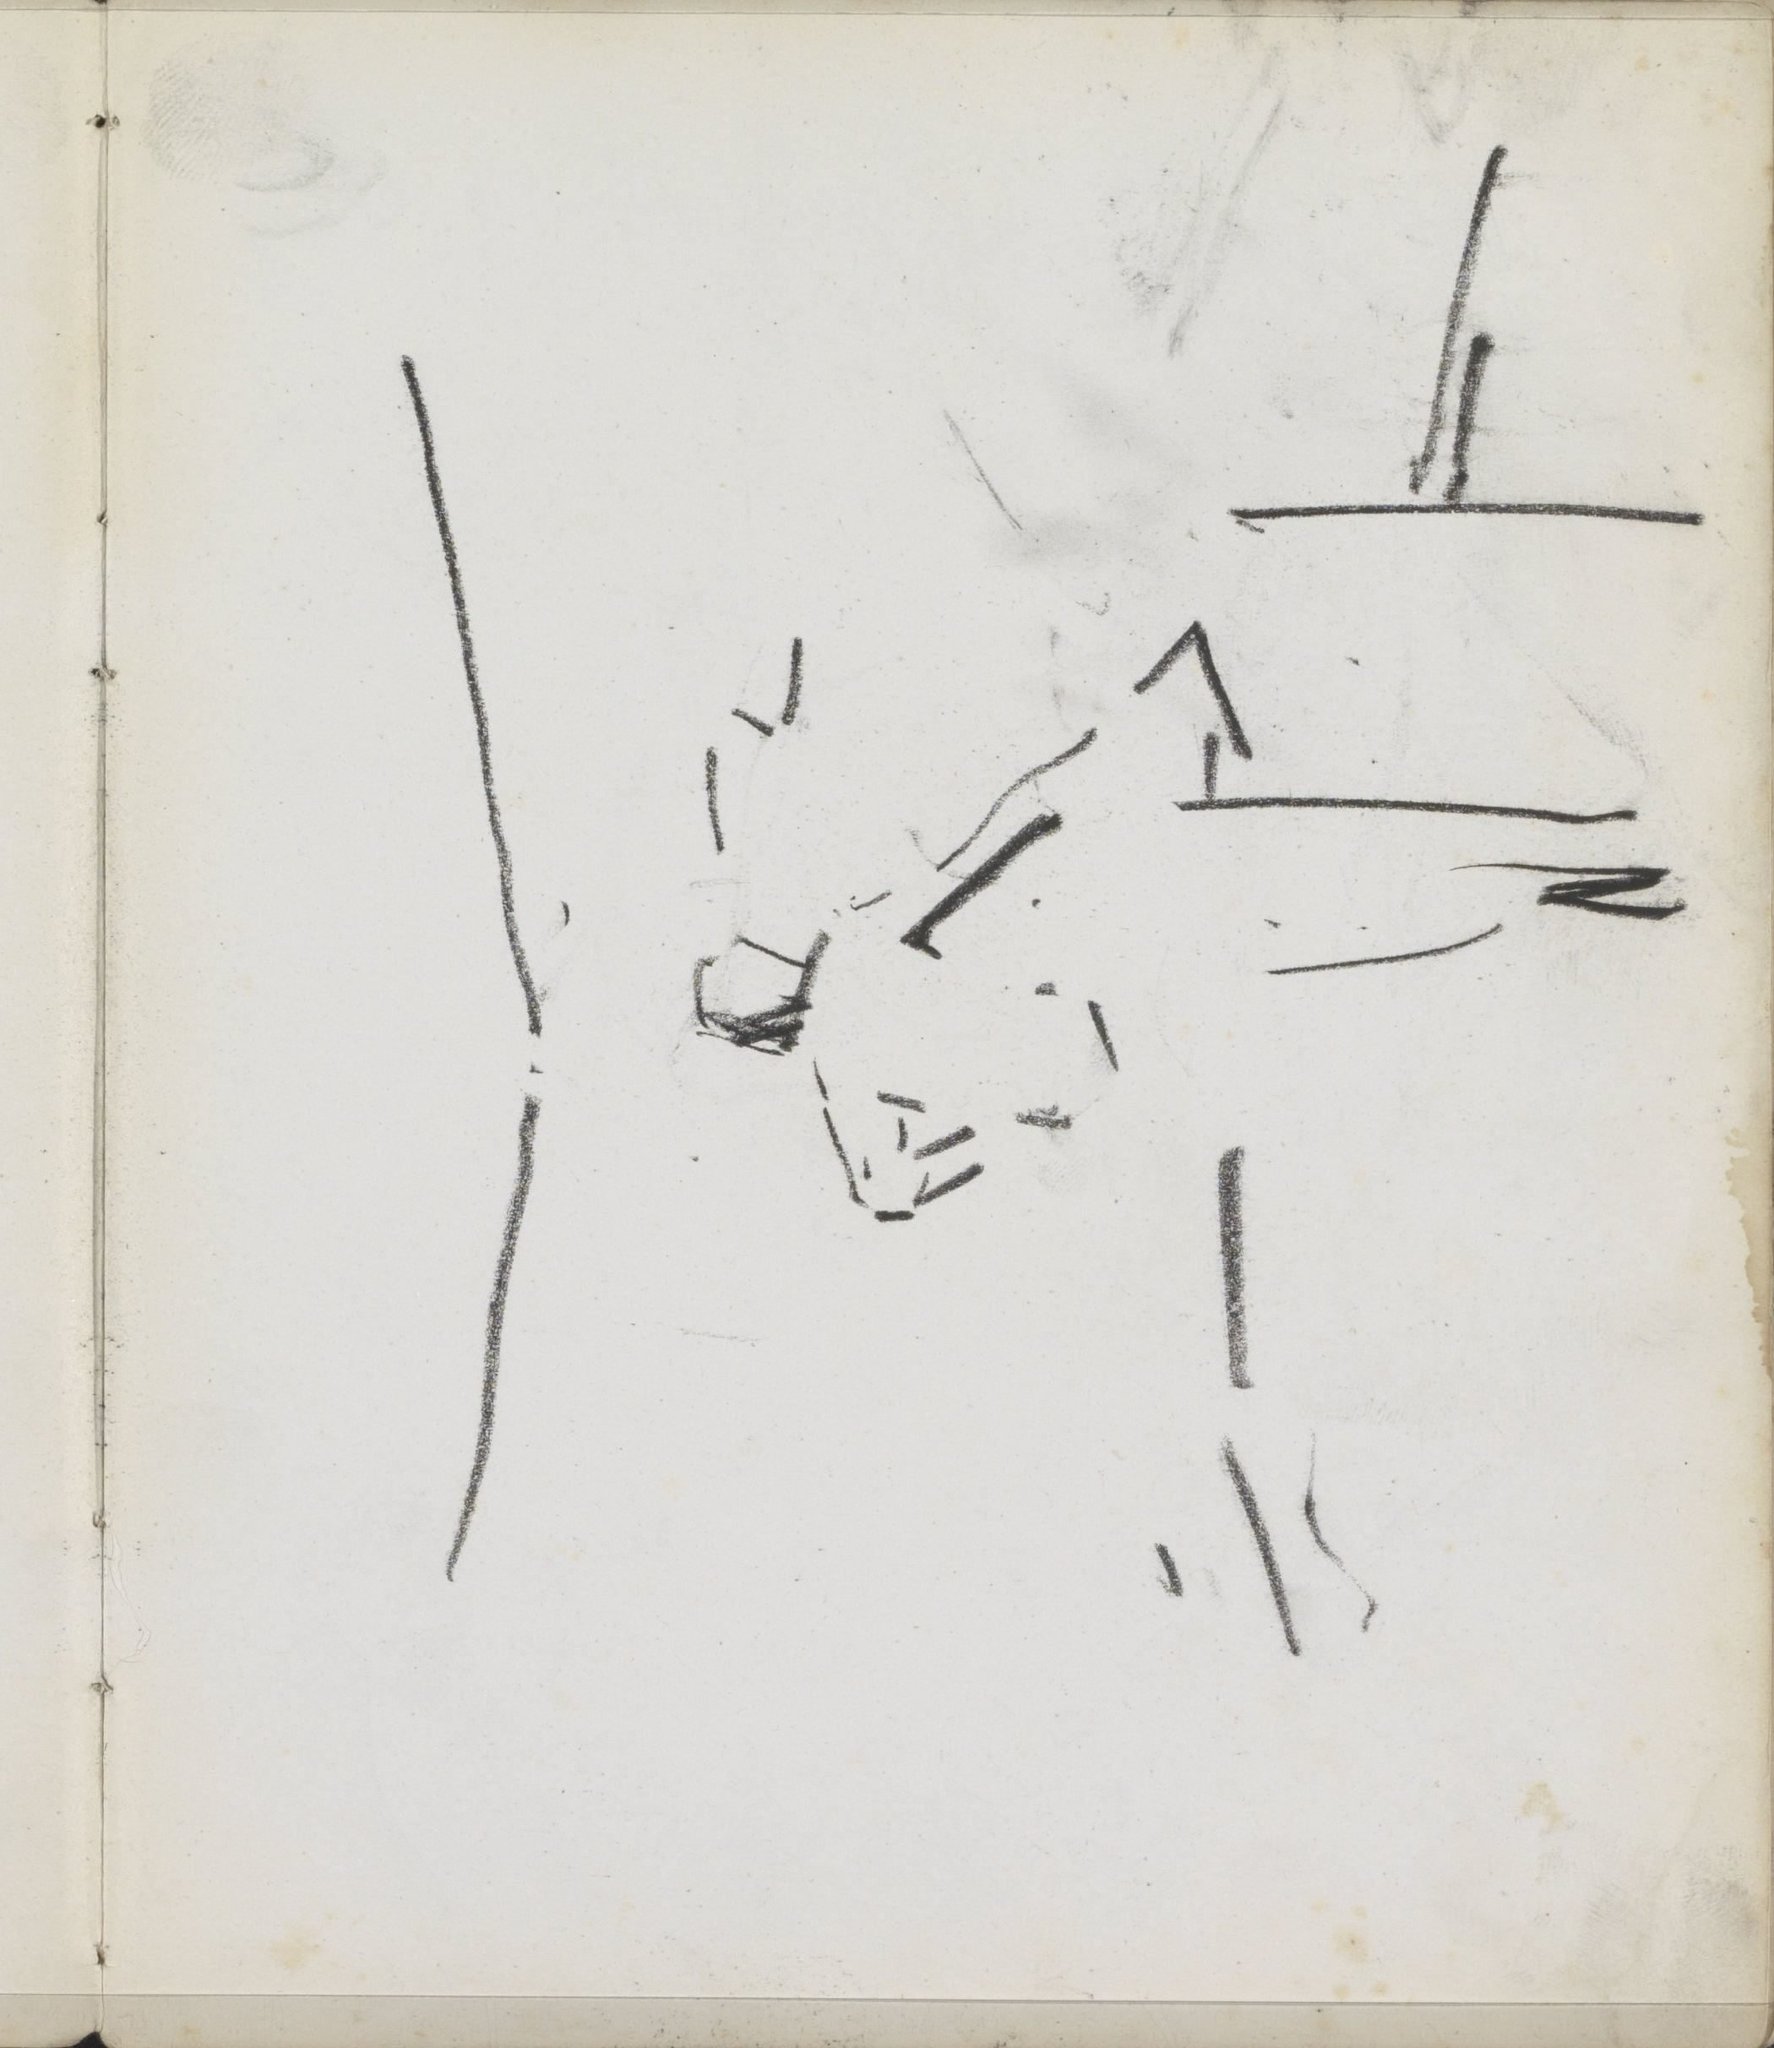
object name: sketchbook leaf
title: Staande man met een hand in de zij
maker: george hendrik breitner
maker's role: draughtsman, painter, print maker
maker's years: 1857-1923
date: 1880-1906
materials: chalk, paper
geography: netherlands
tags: standing figure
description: Pagina 6 uit een schetsboek met 81 bladen.